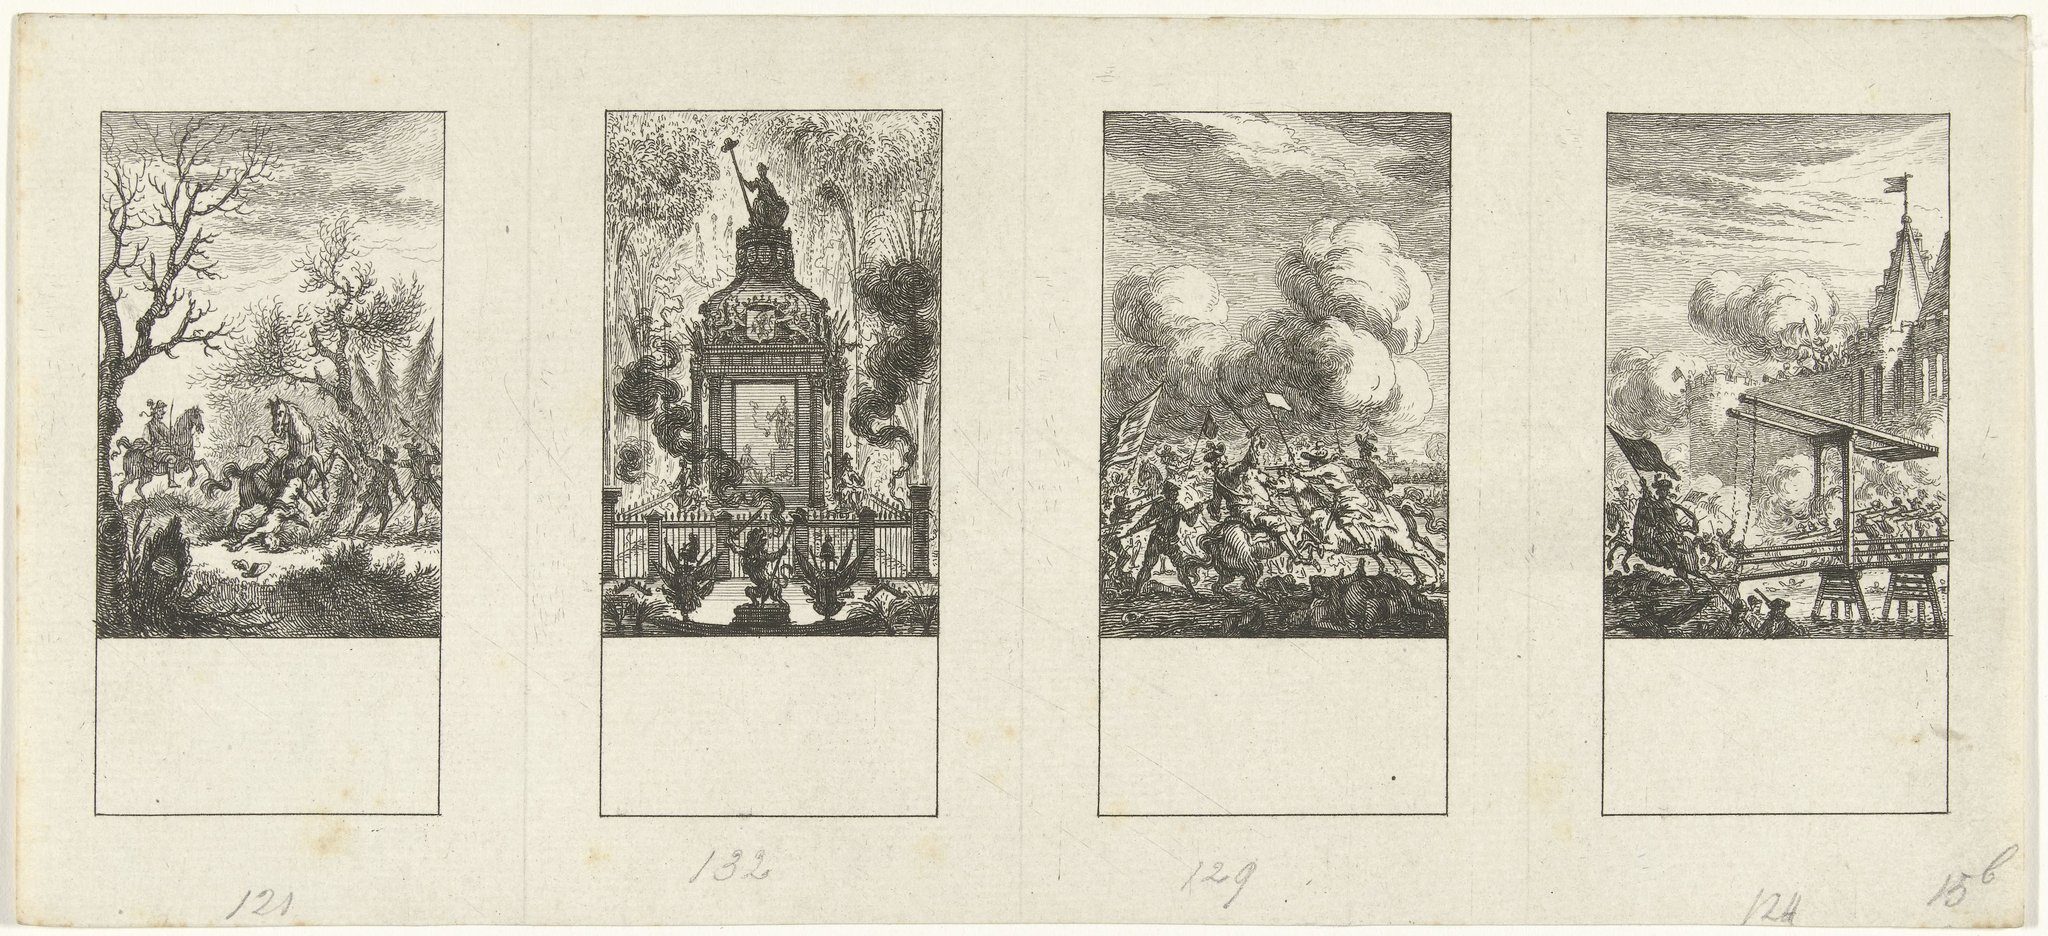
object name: print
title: Illustraties vaderlandse geschiedenis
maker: simon fokke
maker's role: draughtsman, print maker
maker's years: 1712-1784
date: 1722-1784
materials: paper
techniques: etching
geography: amsterdam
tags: the hague, william iii (prince of orange and king of england, scotland, and ireland), historical events and situations, historical persons (portraits and scenes from the life)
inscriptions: collector's mark: Lugt 2228, number: ‘121, 132, 129, 124’